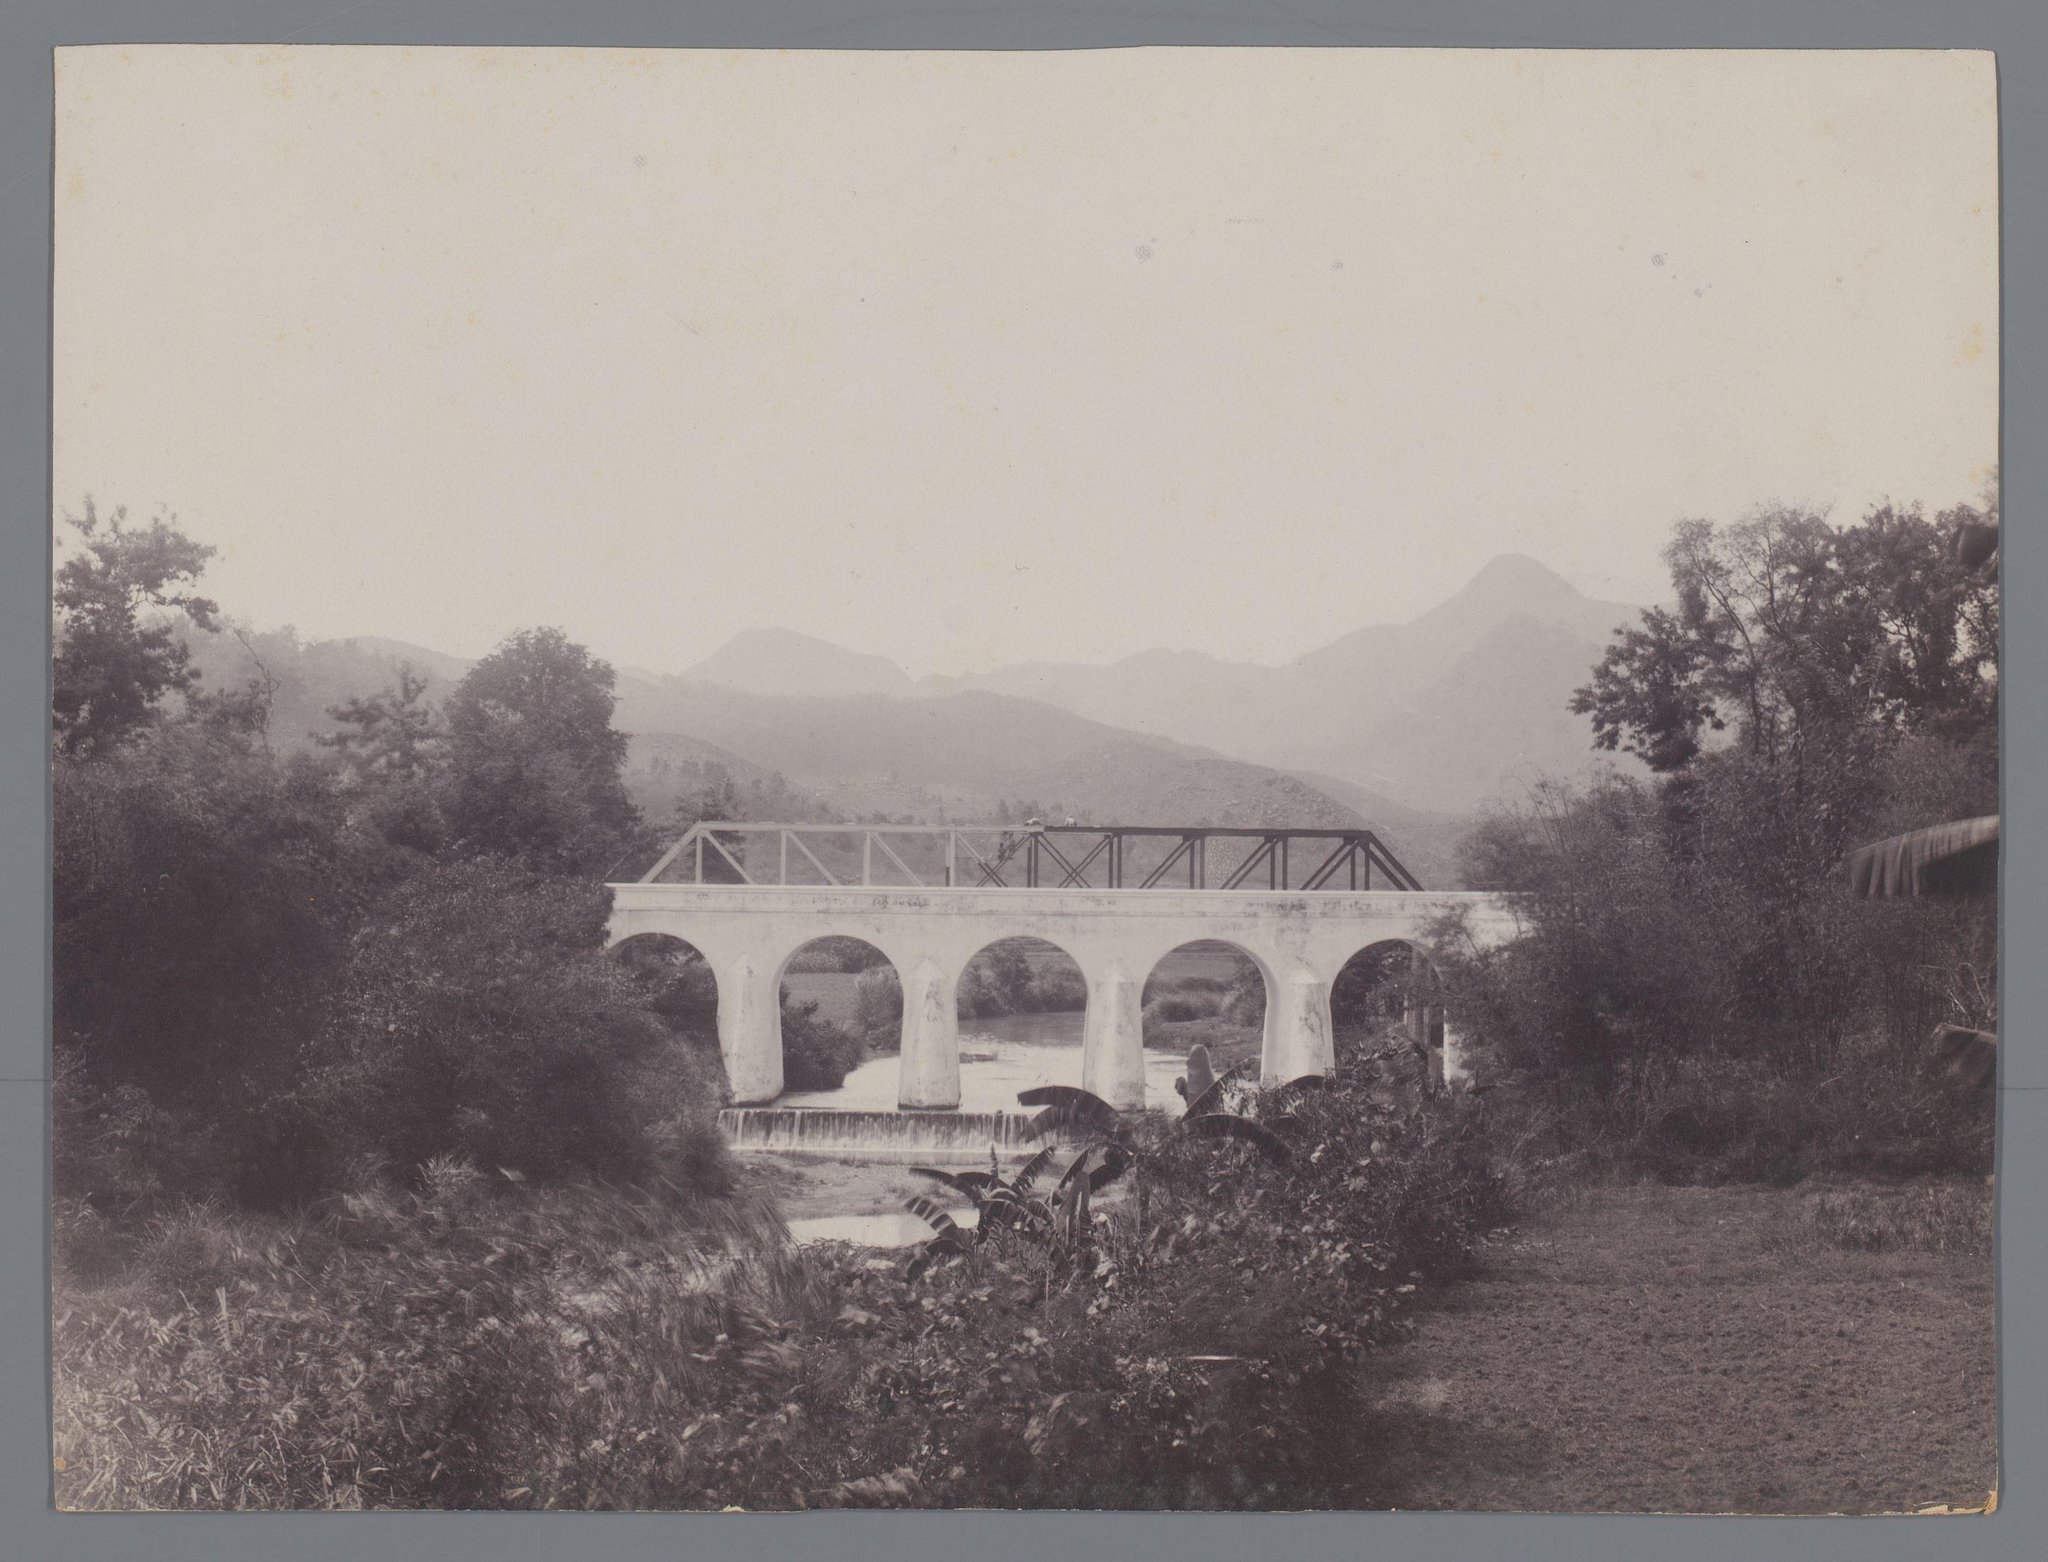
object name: photograph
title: Brug in Nederlands-Indië met bergen op de achtergrond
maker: Anonymous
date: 1900-1920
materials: paper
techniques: gelatin silver print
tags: dutch east indies, the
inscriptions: number: ‘No. 25 b’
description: Brug in Nederlands-Indië met bergen op de achtergrond.